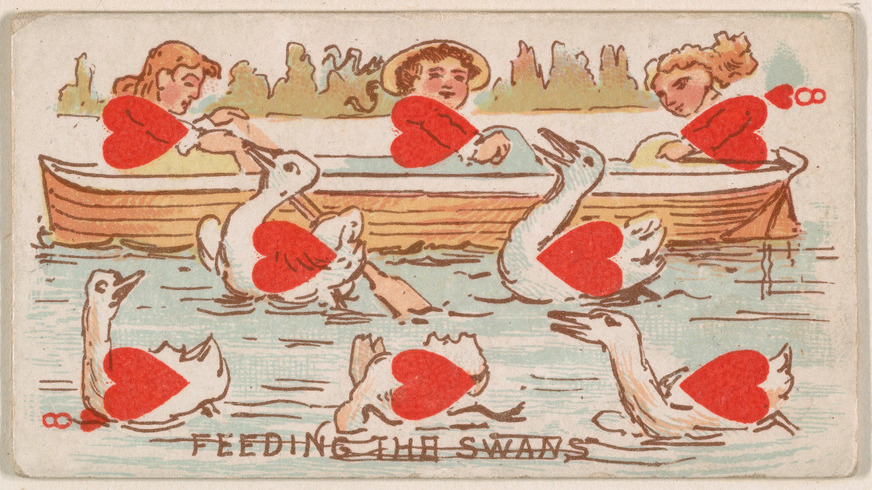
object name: print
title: Eight of Hearts, Feeding the Swans, from Harlequin Cards, 2nd Series (N220) issued by Kinney Bros.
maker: kinney brothers tobacco company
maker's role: publisher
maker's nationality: american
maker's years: 1869-2011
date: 1889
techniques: color lithograph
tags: playing cards,boats